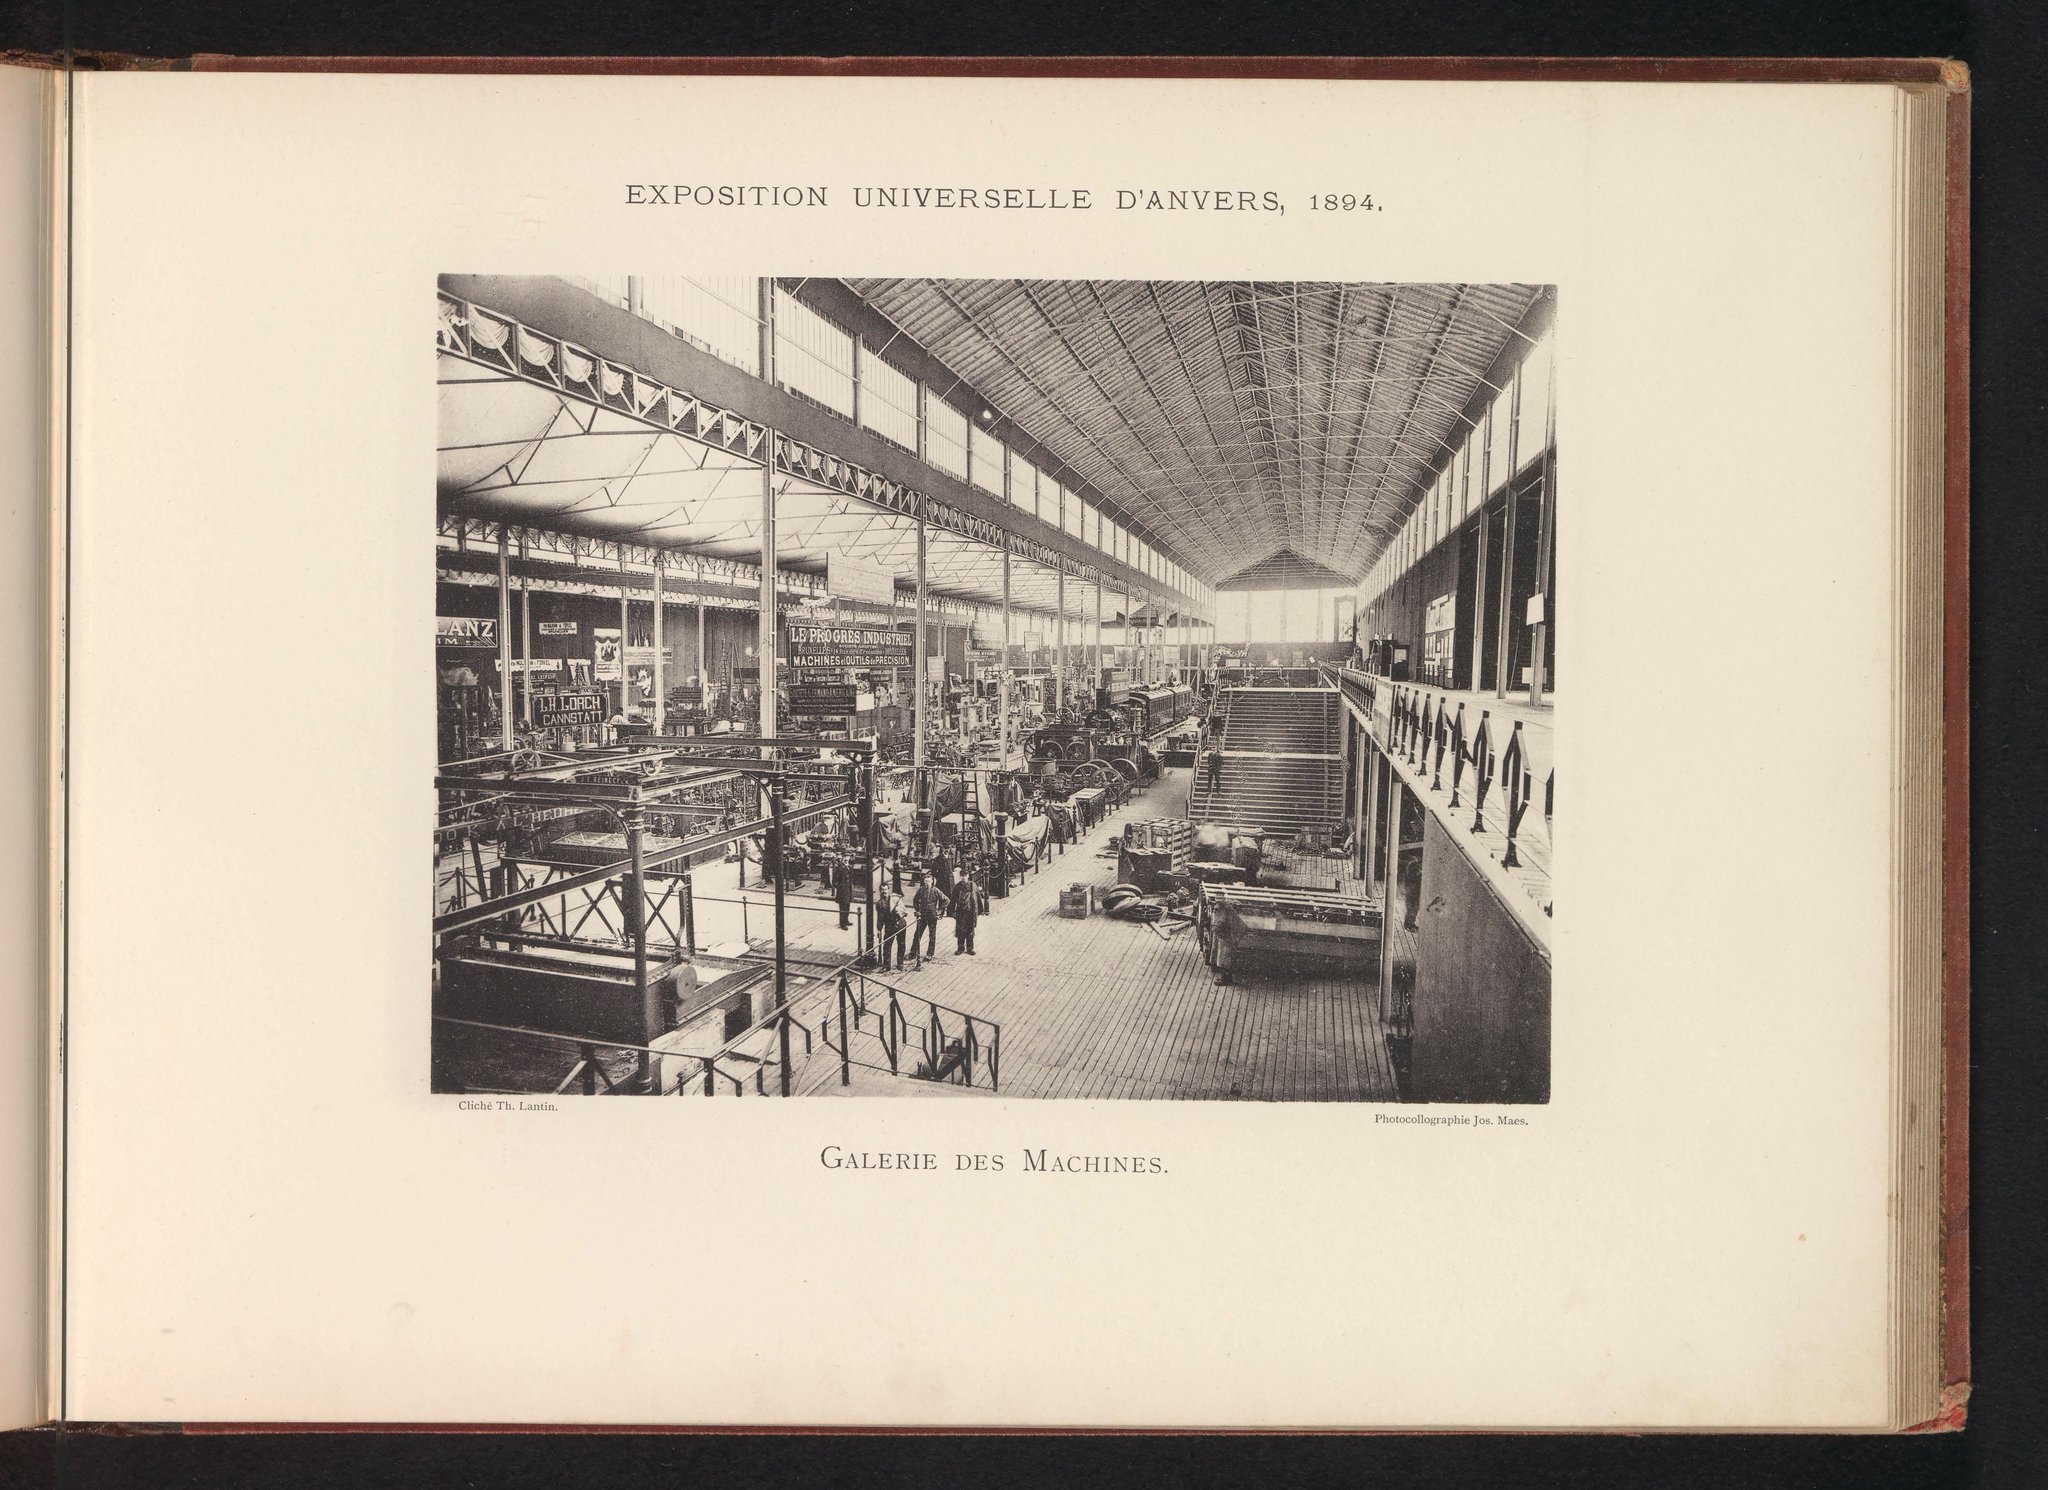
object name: page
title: Interieur van de machinehal tijdens de wereldtentoonstelling te Antwerpen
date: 1894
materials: paper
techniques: photograph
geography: antwerp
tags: machines; parts of machines; tools and appliances, world fair, world exhibition, interior ~ representation of a building, collection, exhibition, show